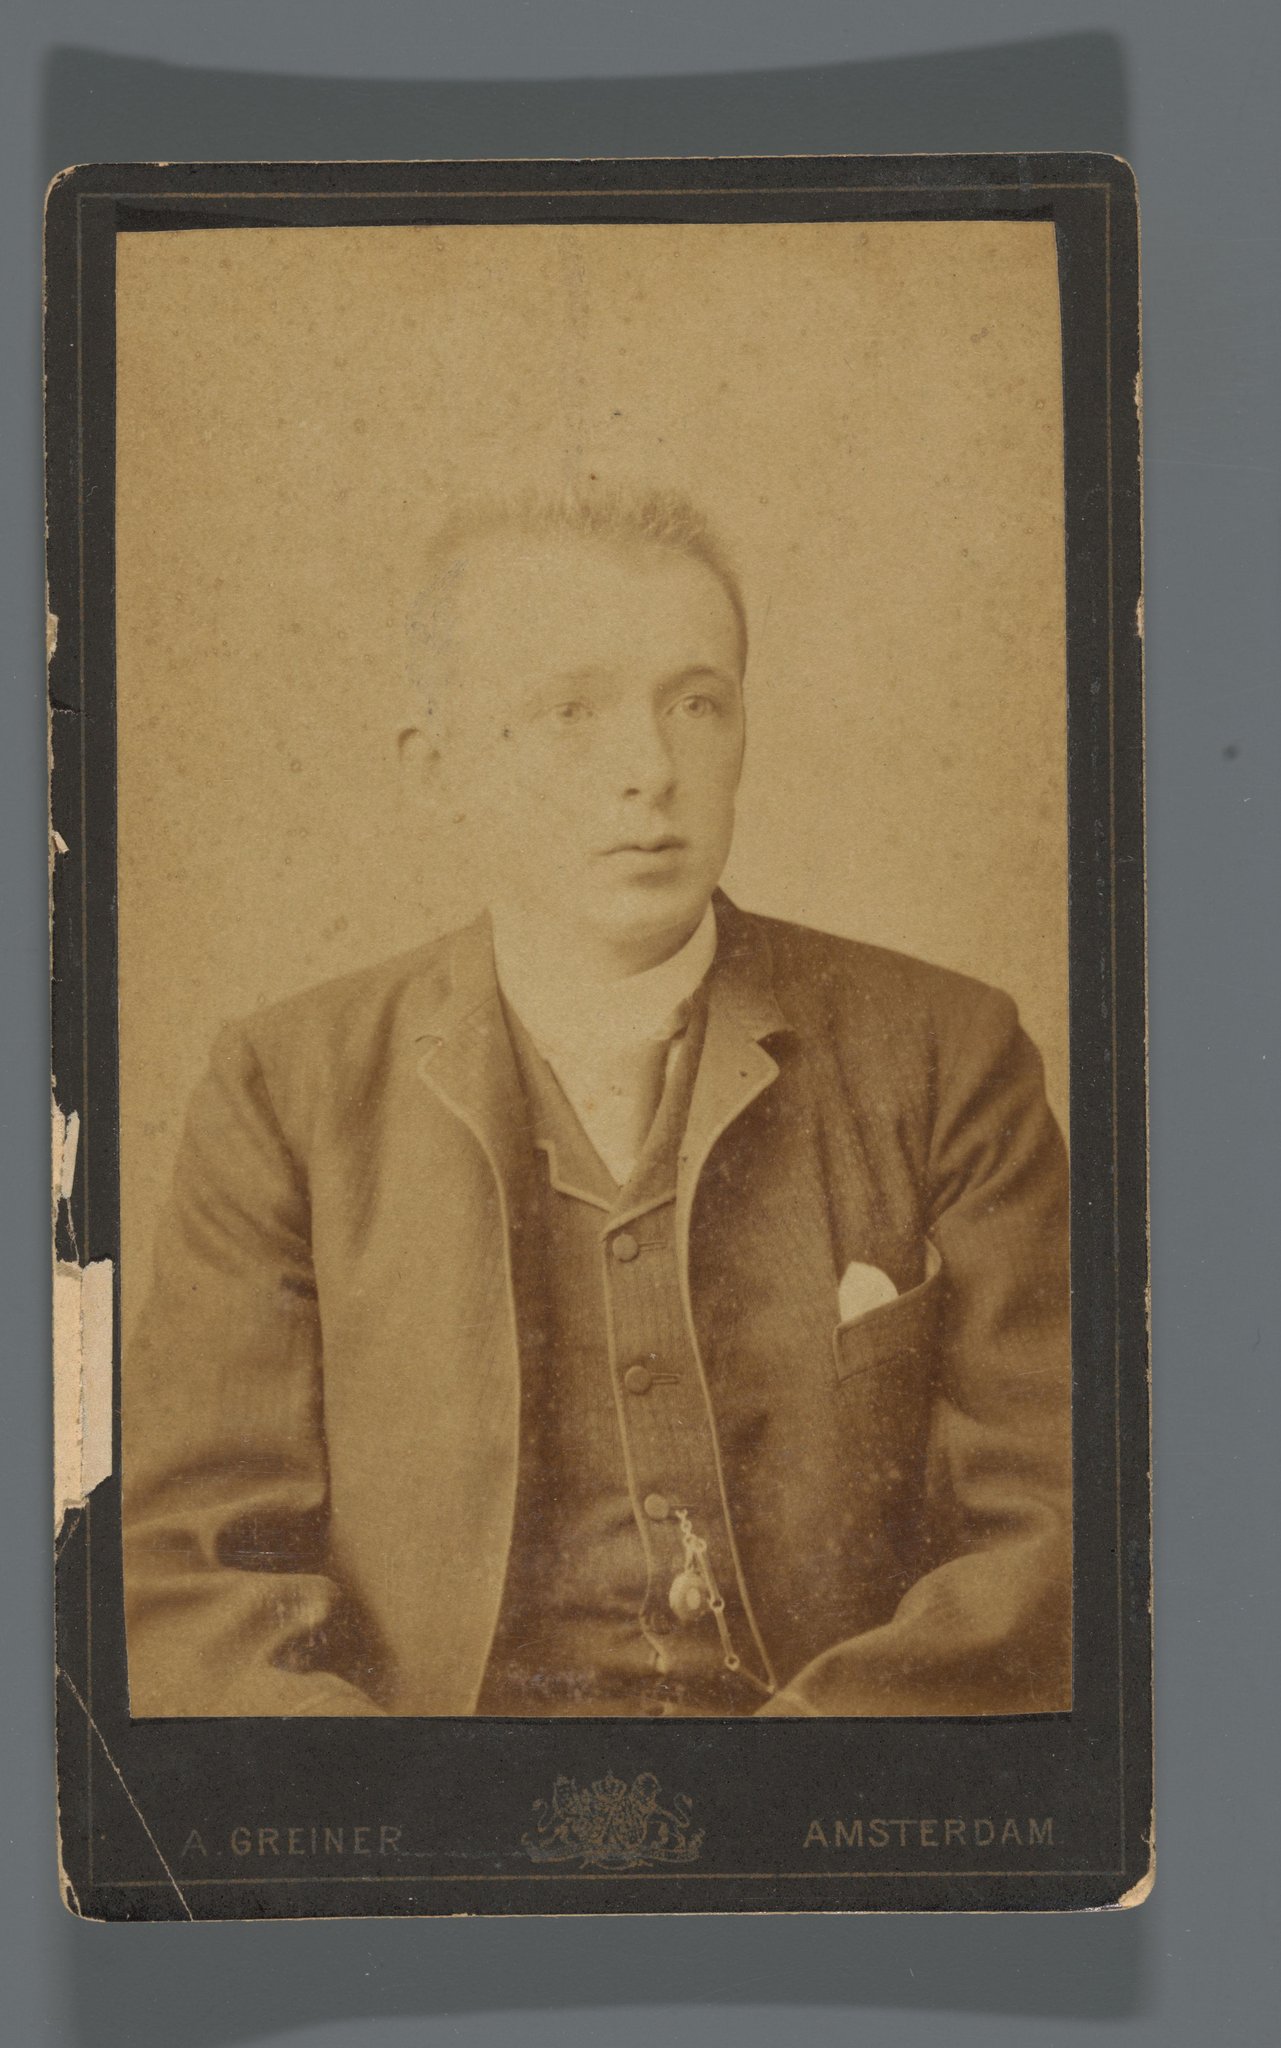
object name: photograph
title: Portret van A.F. Marmelstein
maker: albert greiner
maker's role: fotograaf, fotostudio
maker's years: 1833-1890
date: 1870-1900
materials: cardboard, photographic support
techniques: albumen print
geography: amsterdam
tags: adult man, historical persons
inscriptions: inscription: ‘Pa’, retailer's mark: ‘Albert Greiner/ Kon. Ned. Hog-Photograaf/ Amsterdam/ Nieuwendijk 89. (...)’